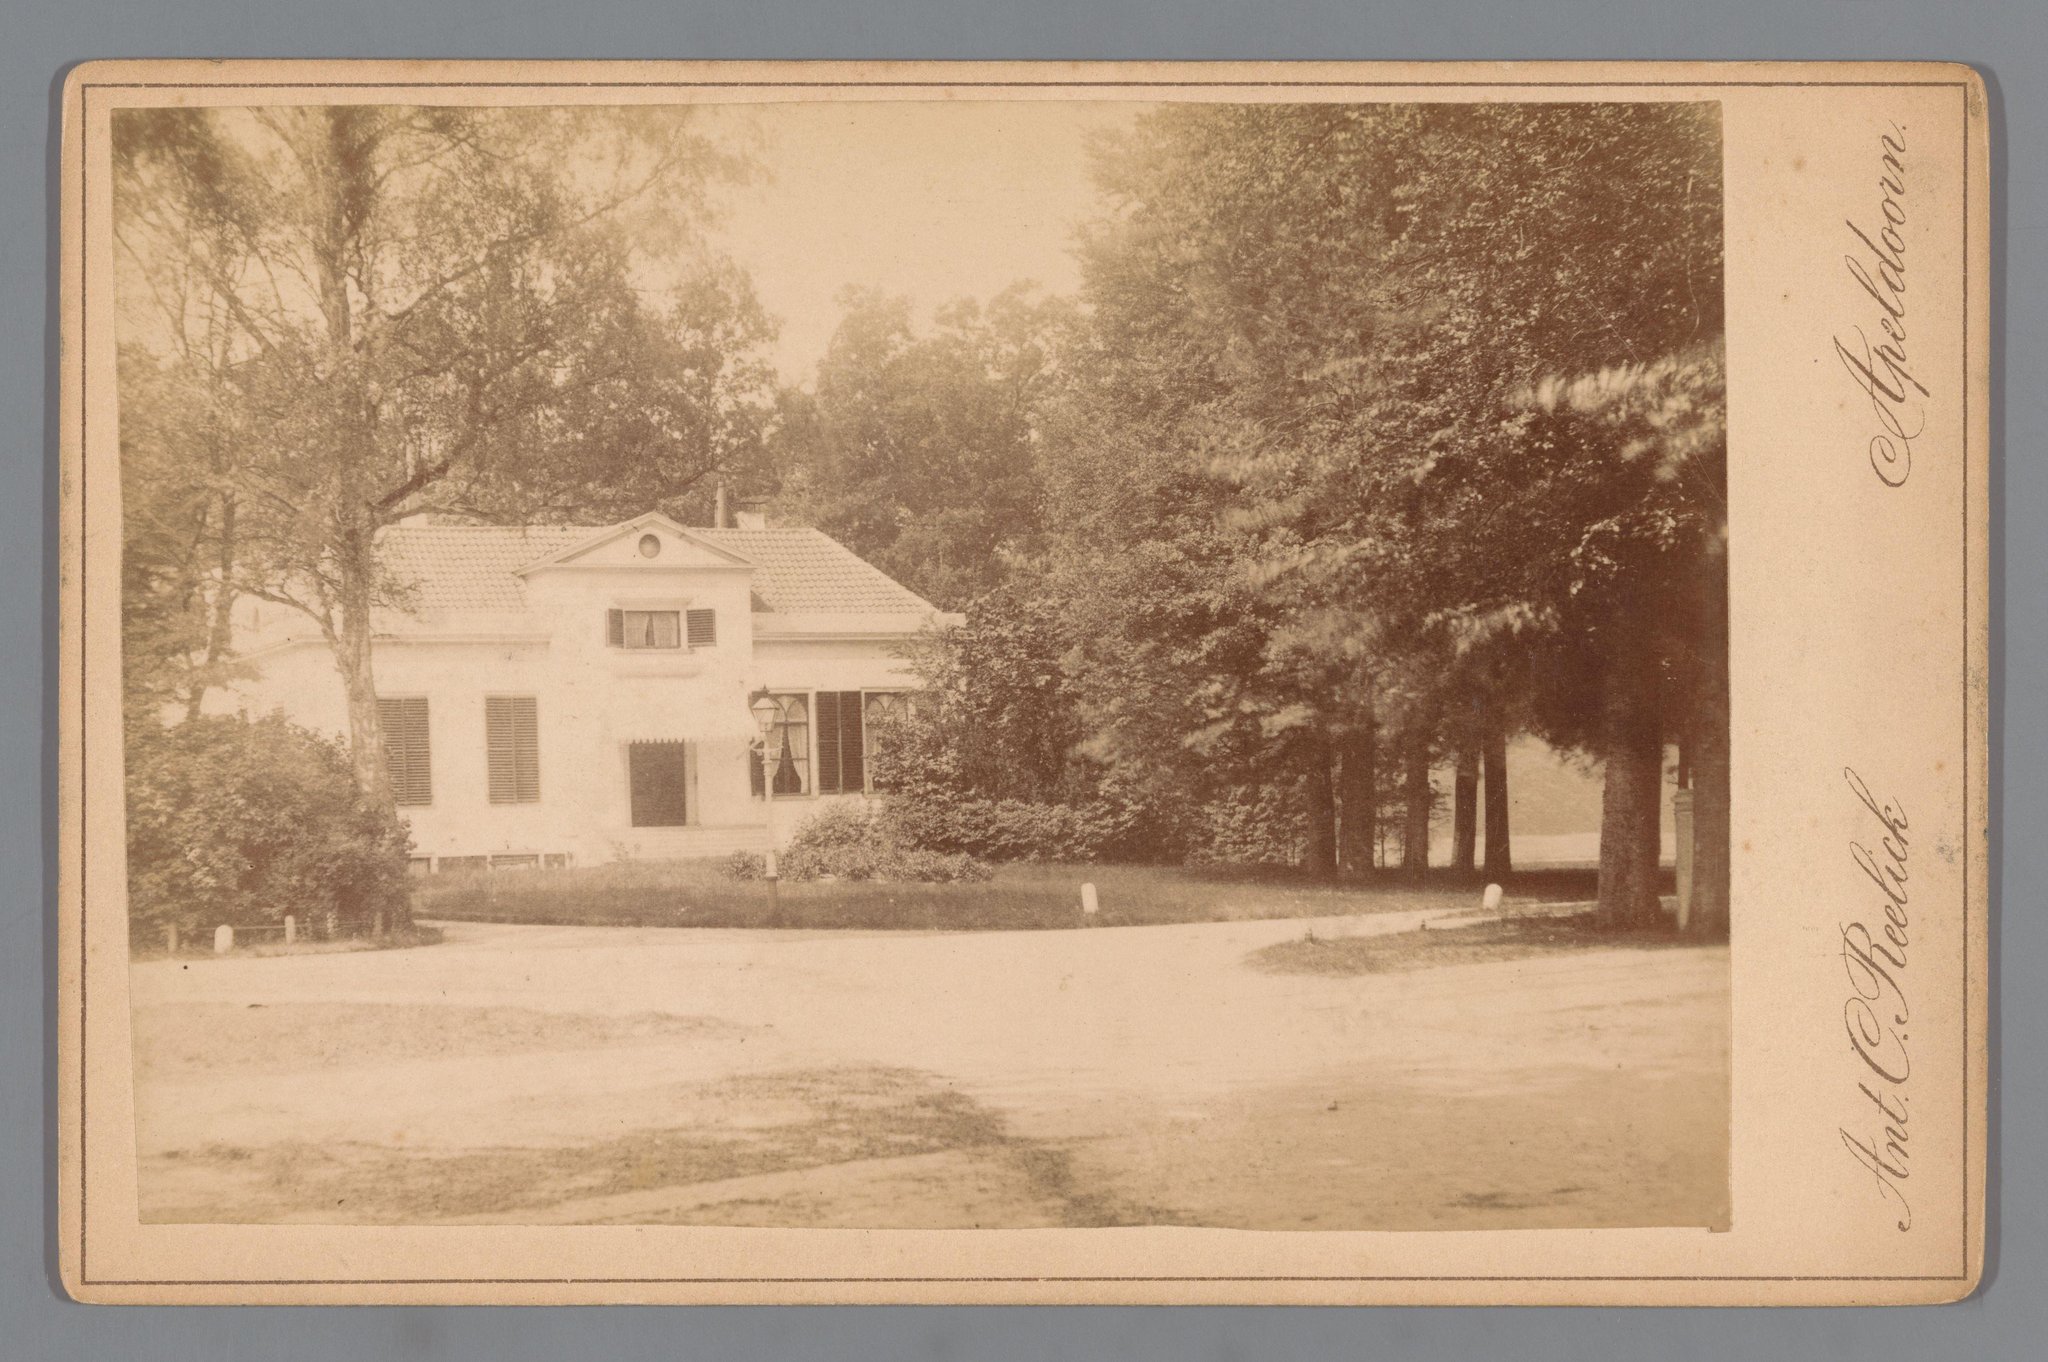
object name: photograph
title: Exterieur van een landhuis aan de Zwolseweg te Apeldoorn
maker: a. c. reelick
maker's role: fotograaf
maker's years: 1851-1924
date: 1880-1900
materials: cardboard, photographic support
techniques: albumen print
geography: apeldoorn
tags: rural housing, e.g. country-house, villa, cottage, façade (of house or building)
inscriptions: inscription: ‘Ant. C. Reelick Photograaf Apeldoorn. Speciale inrichting voor vergrootingen naar ieder portret.’